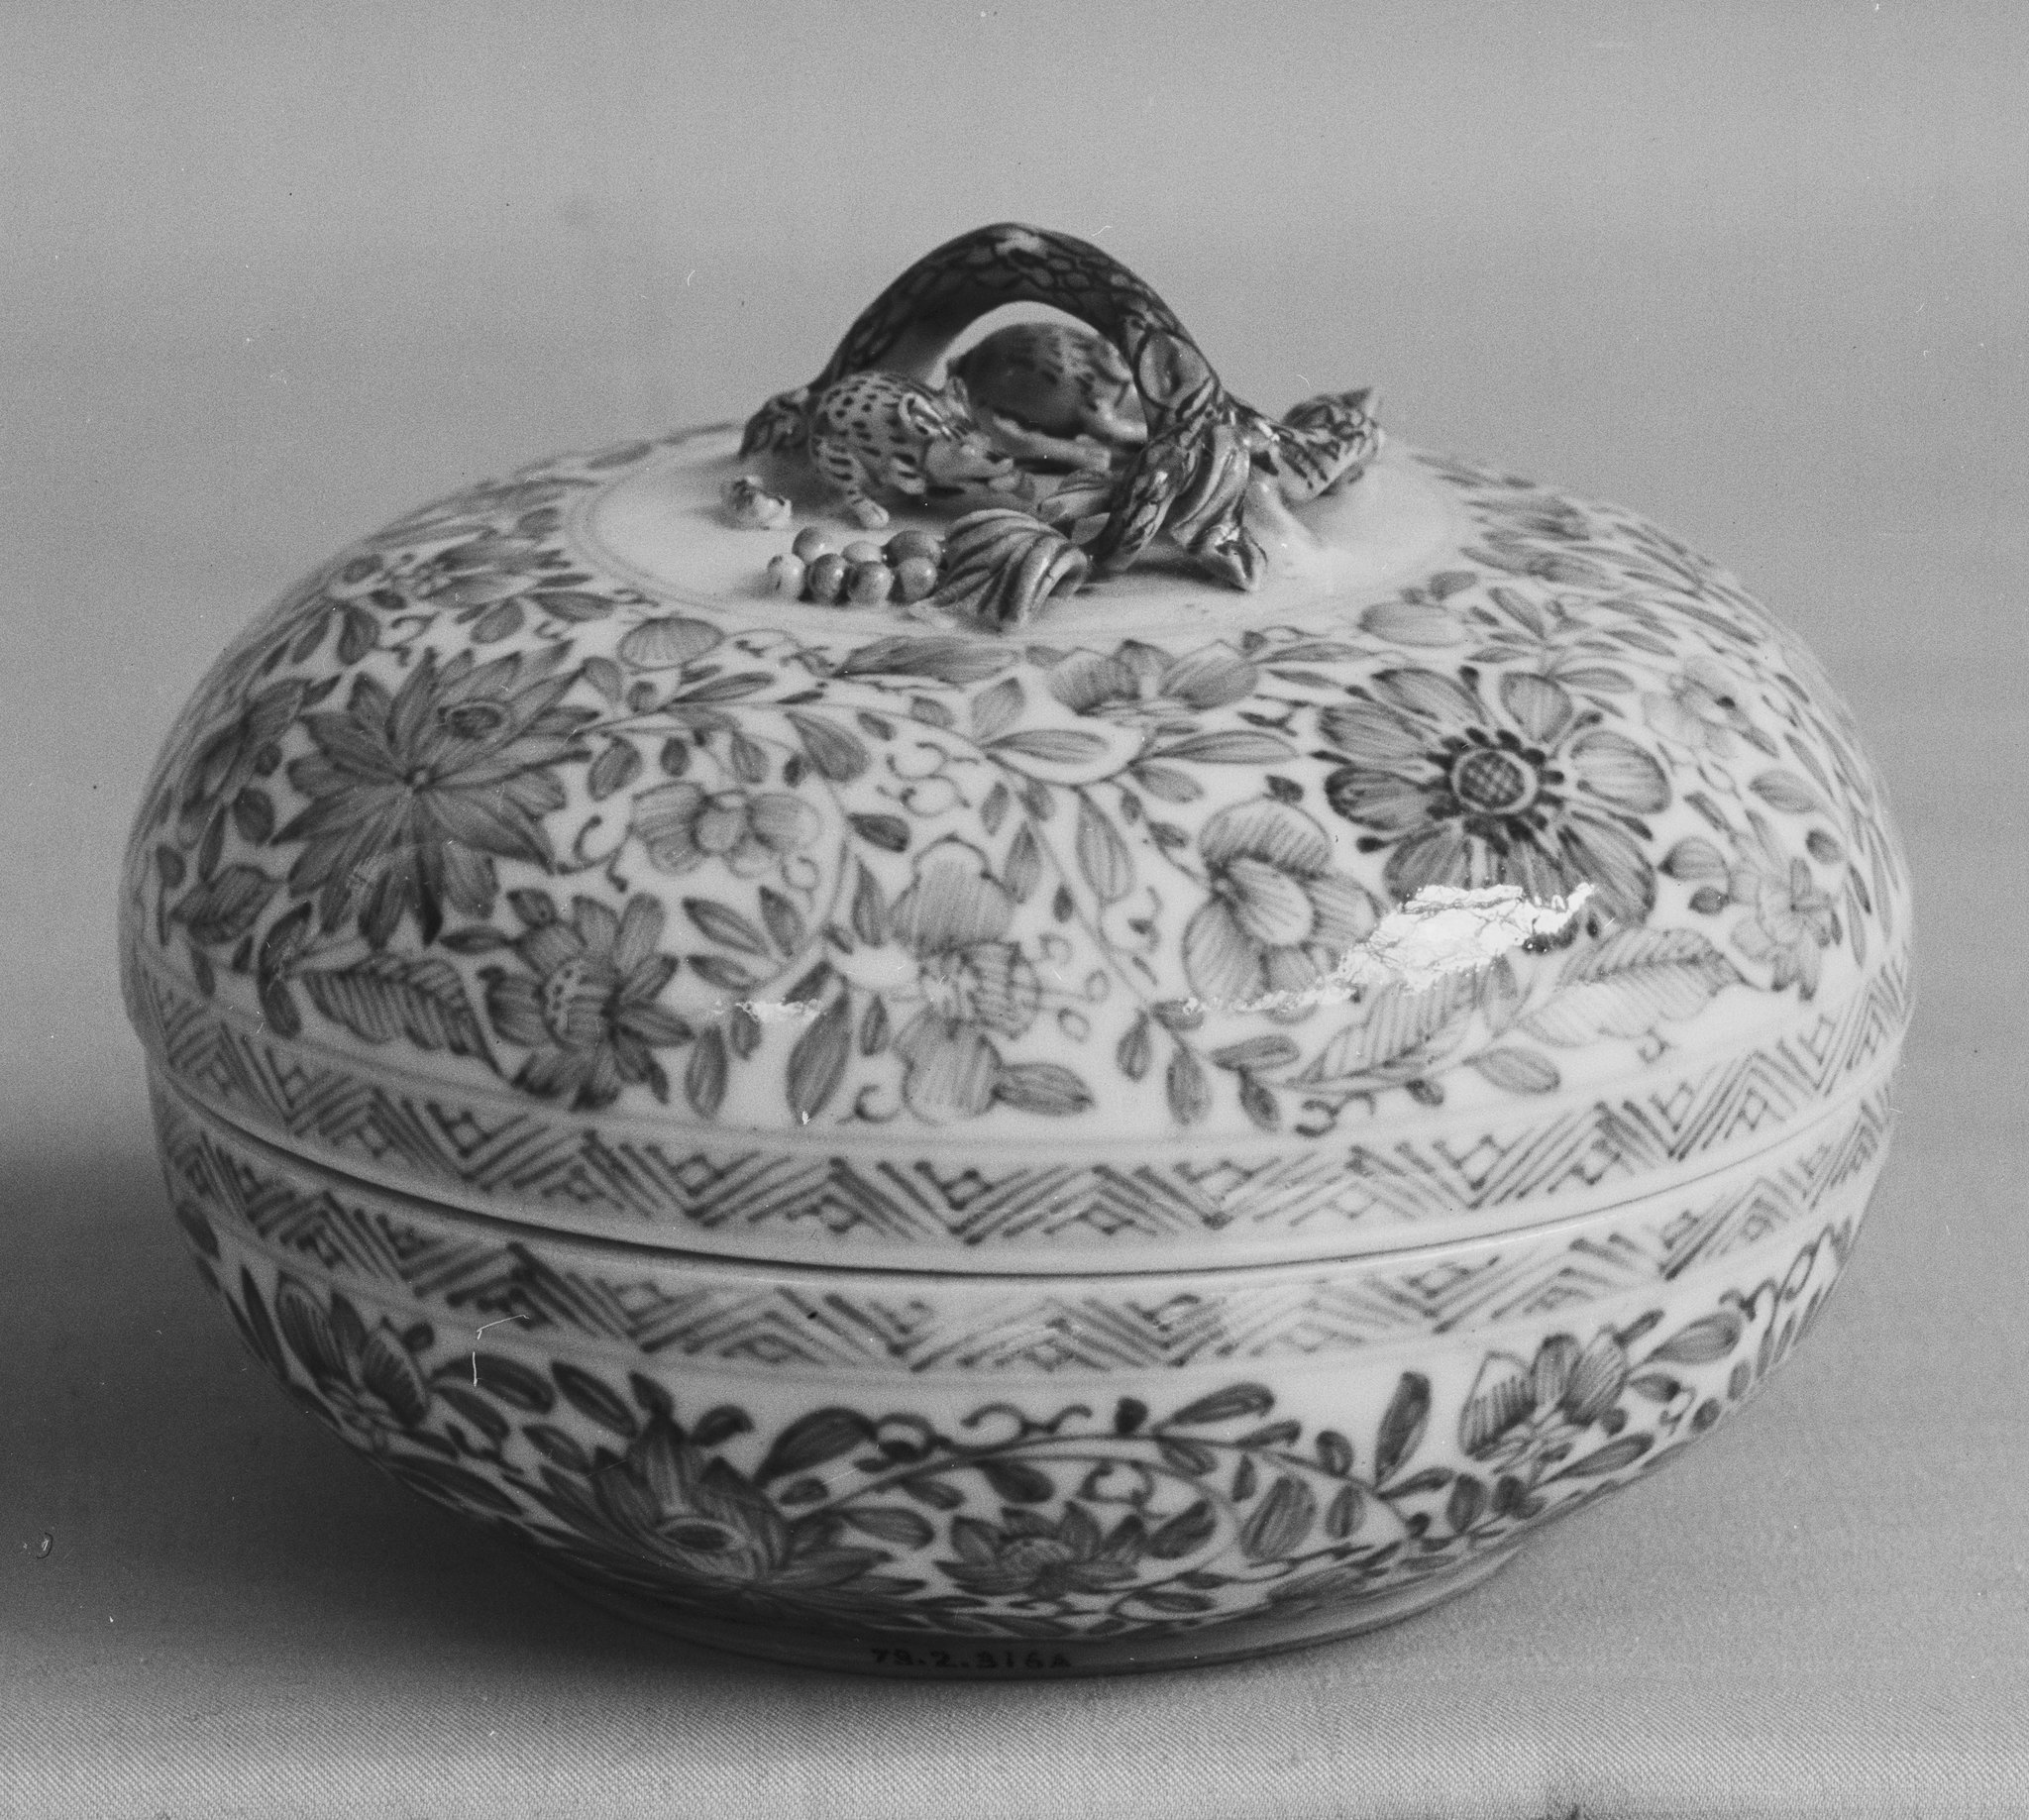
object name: covered box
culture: chinese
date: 1667-1733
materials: enamel, porcelain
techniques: painting, polychrome, relief, underglaze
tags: animals,flowers